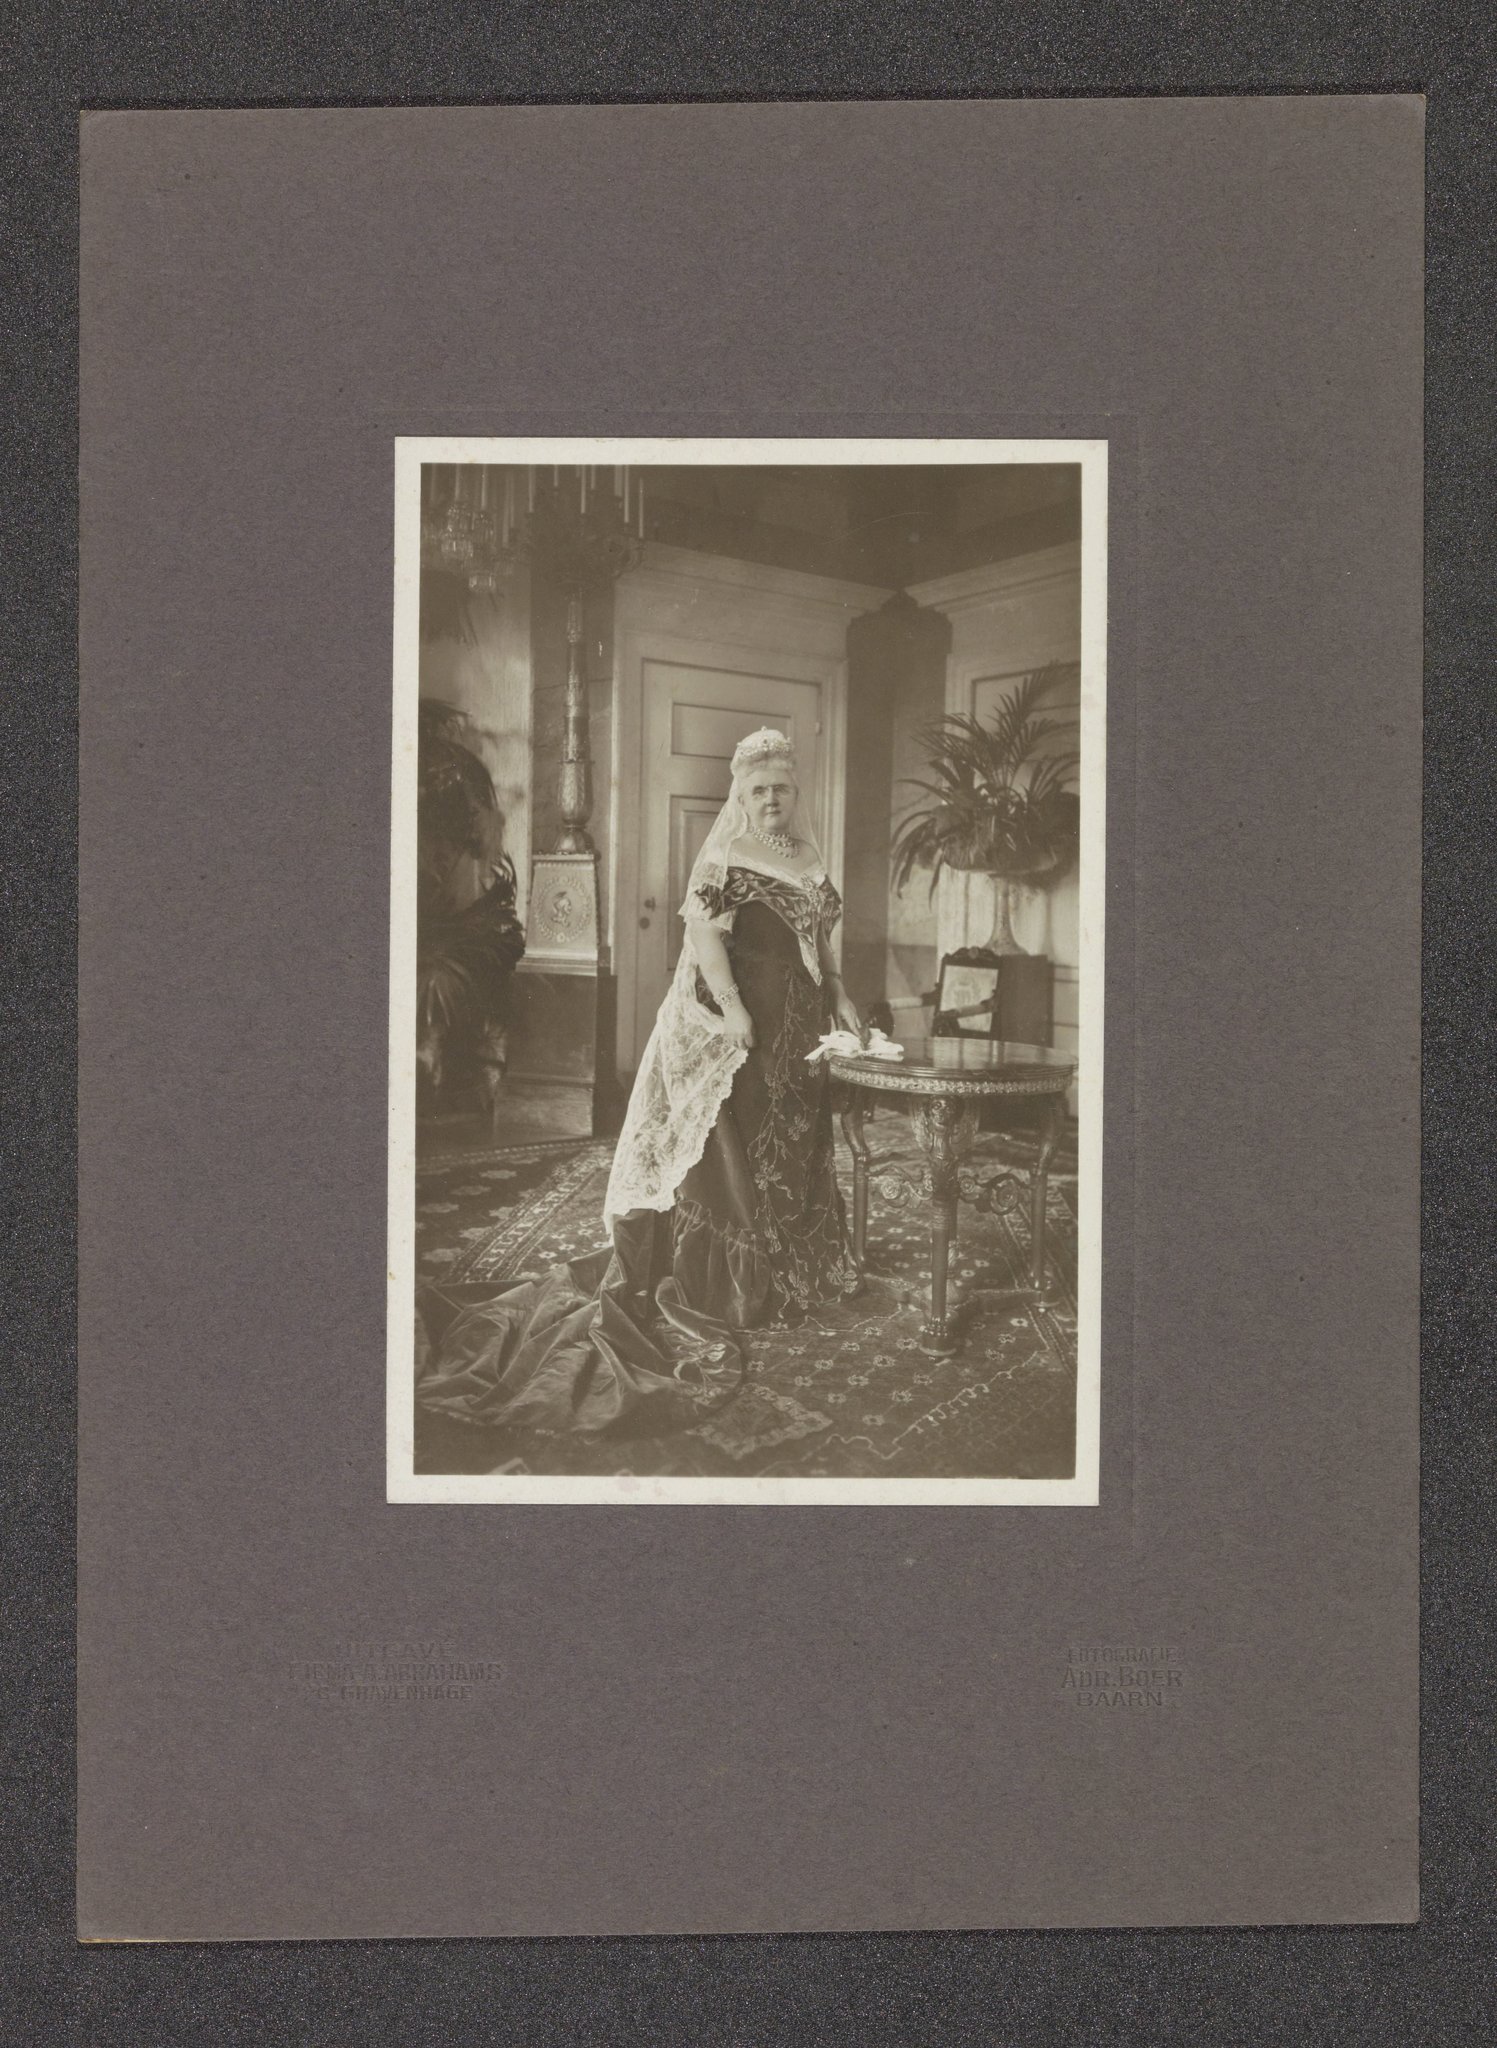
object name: photograph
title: Portret van koningin Emma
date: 1900-1925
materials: cardboard, paper, photographic support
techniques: gelatin silver print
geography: baarn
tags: the hague, emma (queen consort of the netherlands)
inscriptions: signature: ‘UITGAVE / FIRMA A. ABRAHAMS / 'S GRAVENHAGE // FOTOGRAFIE / ADR. BOER / BAARN’